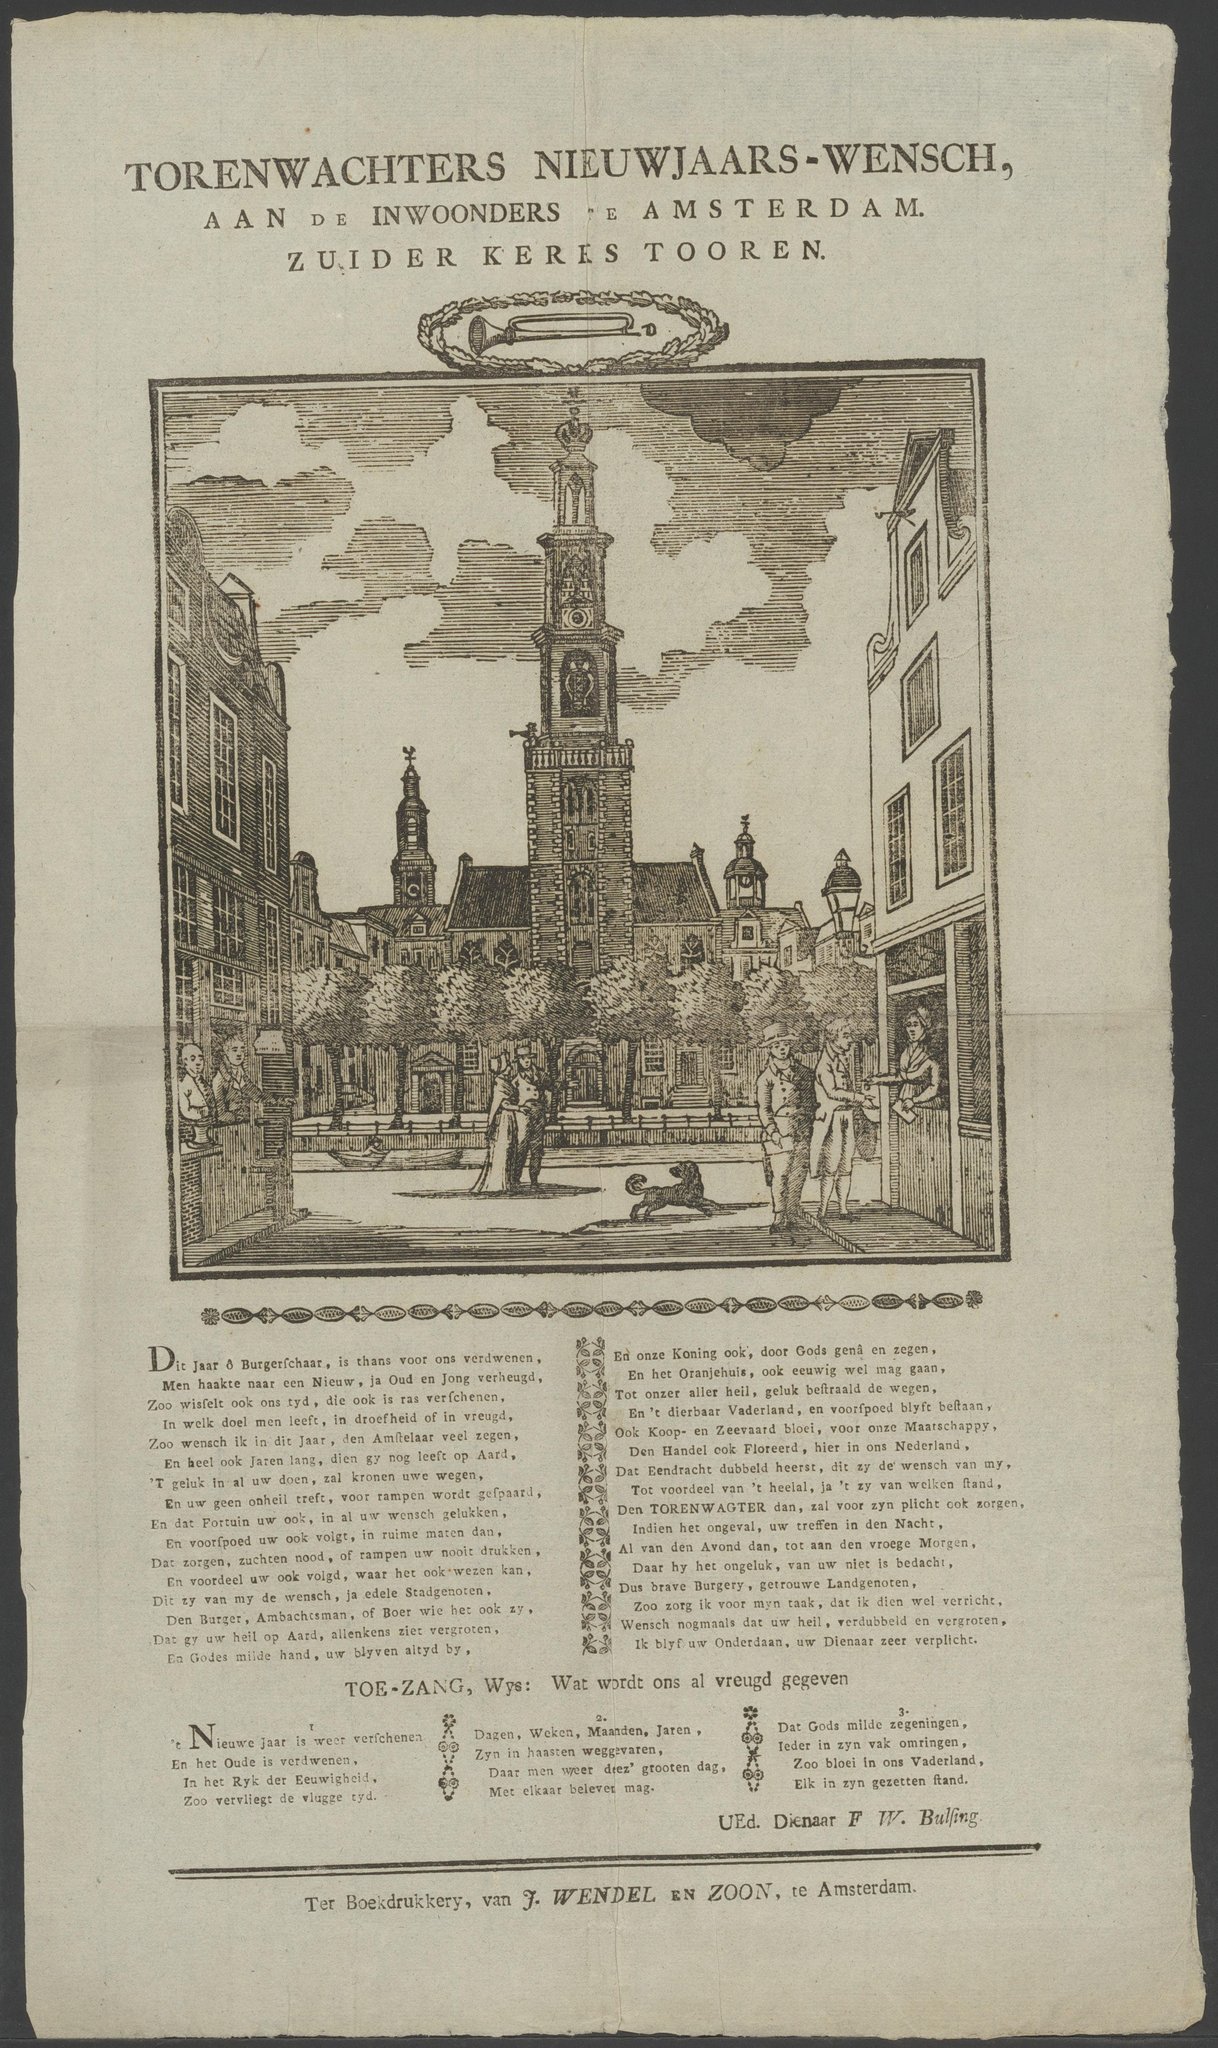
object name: print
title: Torenwachters Nieuwjaars-wensch, aan de inwooners te Amsterdam. Zuider Kerks tooren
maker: Anonymous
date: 1819-1842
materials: paper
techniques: letterpress printing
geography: amsterdam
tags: parts of church exterior and annexes: tower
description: Nieuwjaarswens van de torenwachters van de Zuiderkerkstoren te Amsterdam. Bovenaan een gezicht op de kerktoren. Daaronder centraal een gedicht en onderaan een toezang in drie kolommen. Aangeboden door de torenwachter: F.W. Bulsing. Onderwerpsrubrieken binnen de Atlas Zeden en Gewoonten: Zeden en gewoonten in engeren zin, Volksleven, Volksbladen, Nieuwjaars- en Kerstwenschen, Amsterdam.